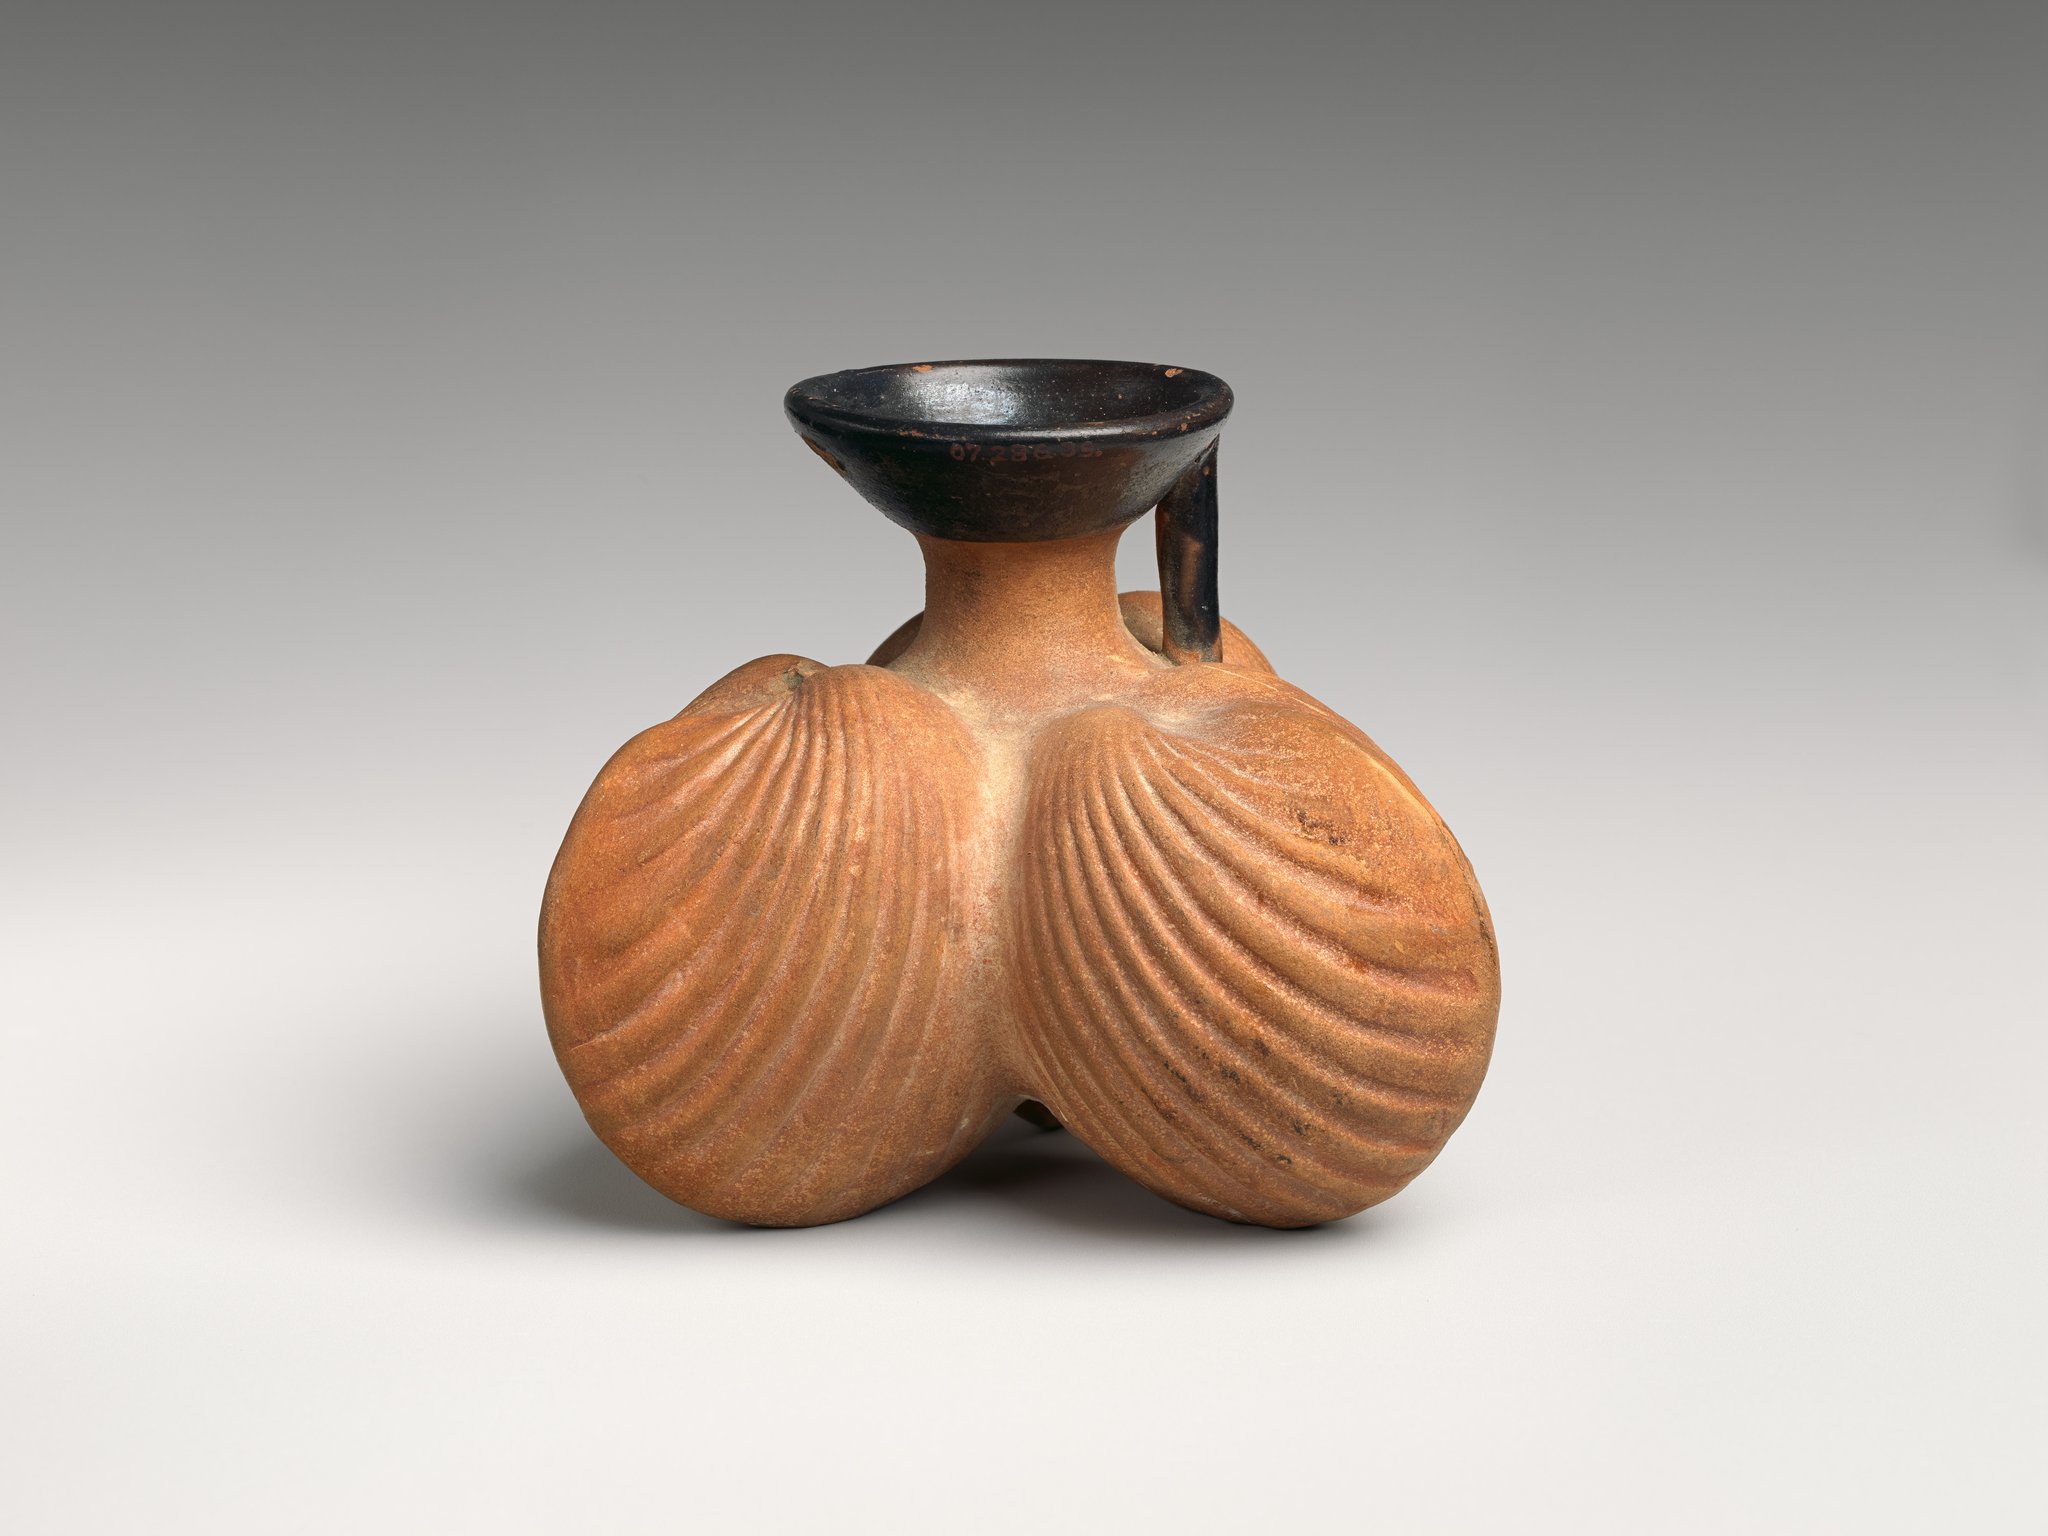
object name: aryballos in the form of three cockleshell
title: Terracotta aryballos (oil flask) in the form of three cockleshells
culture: greek, attic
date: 400-301 BCE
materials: terracotta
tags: shells